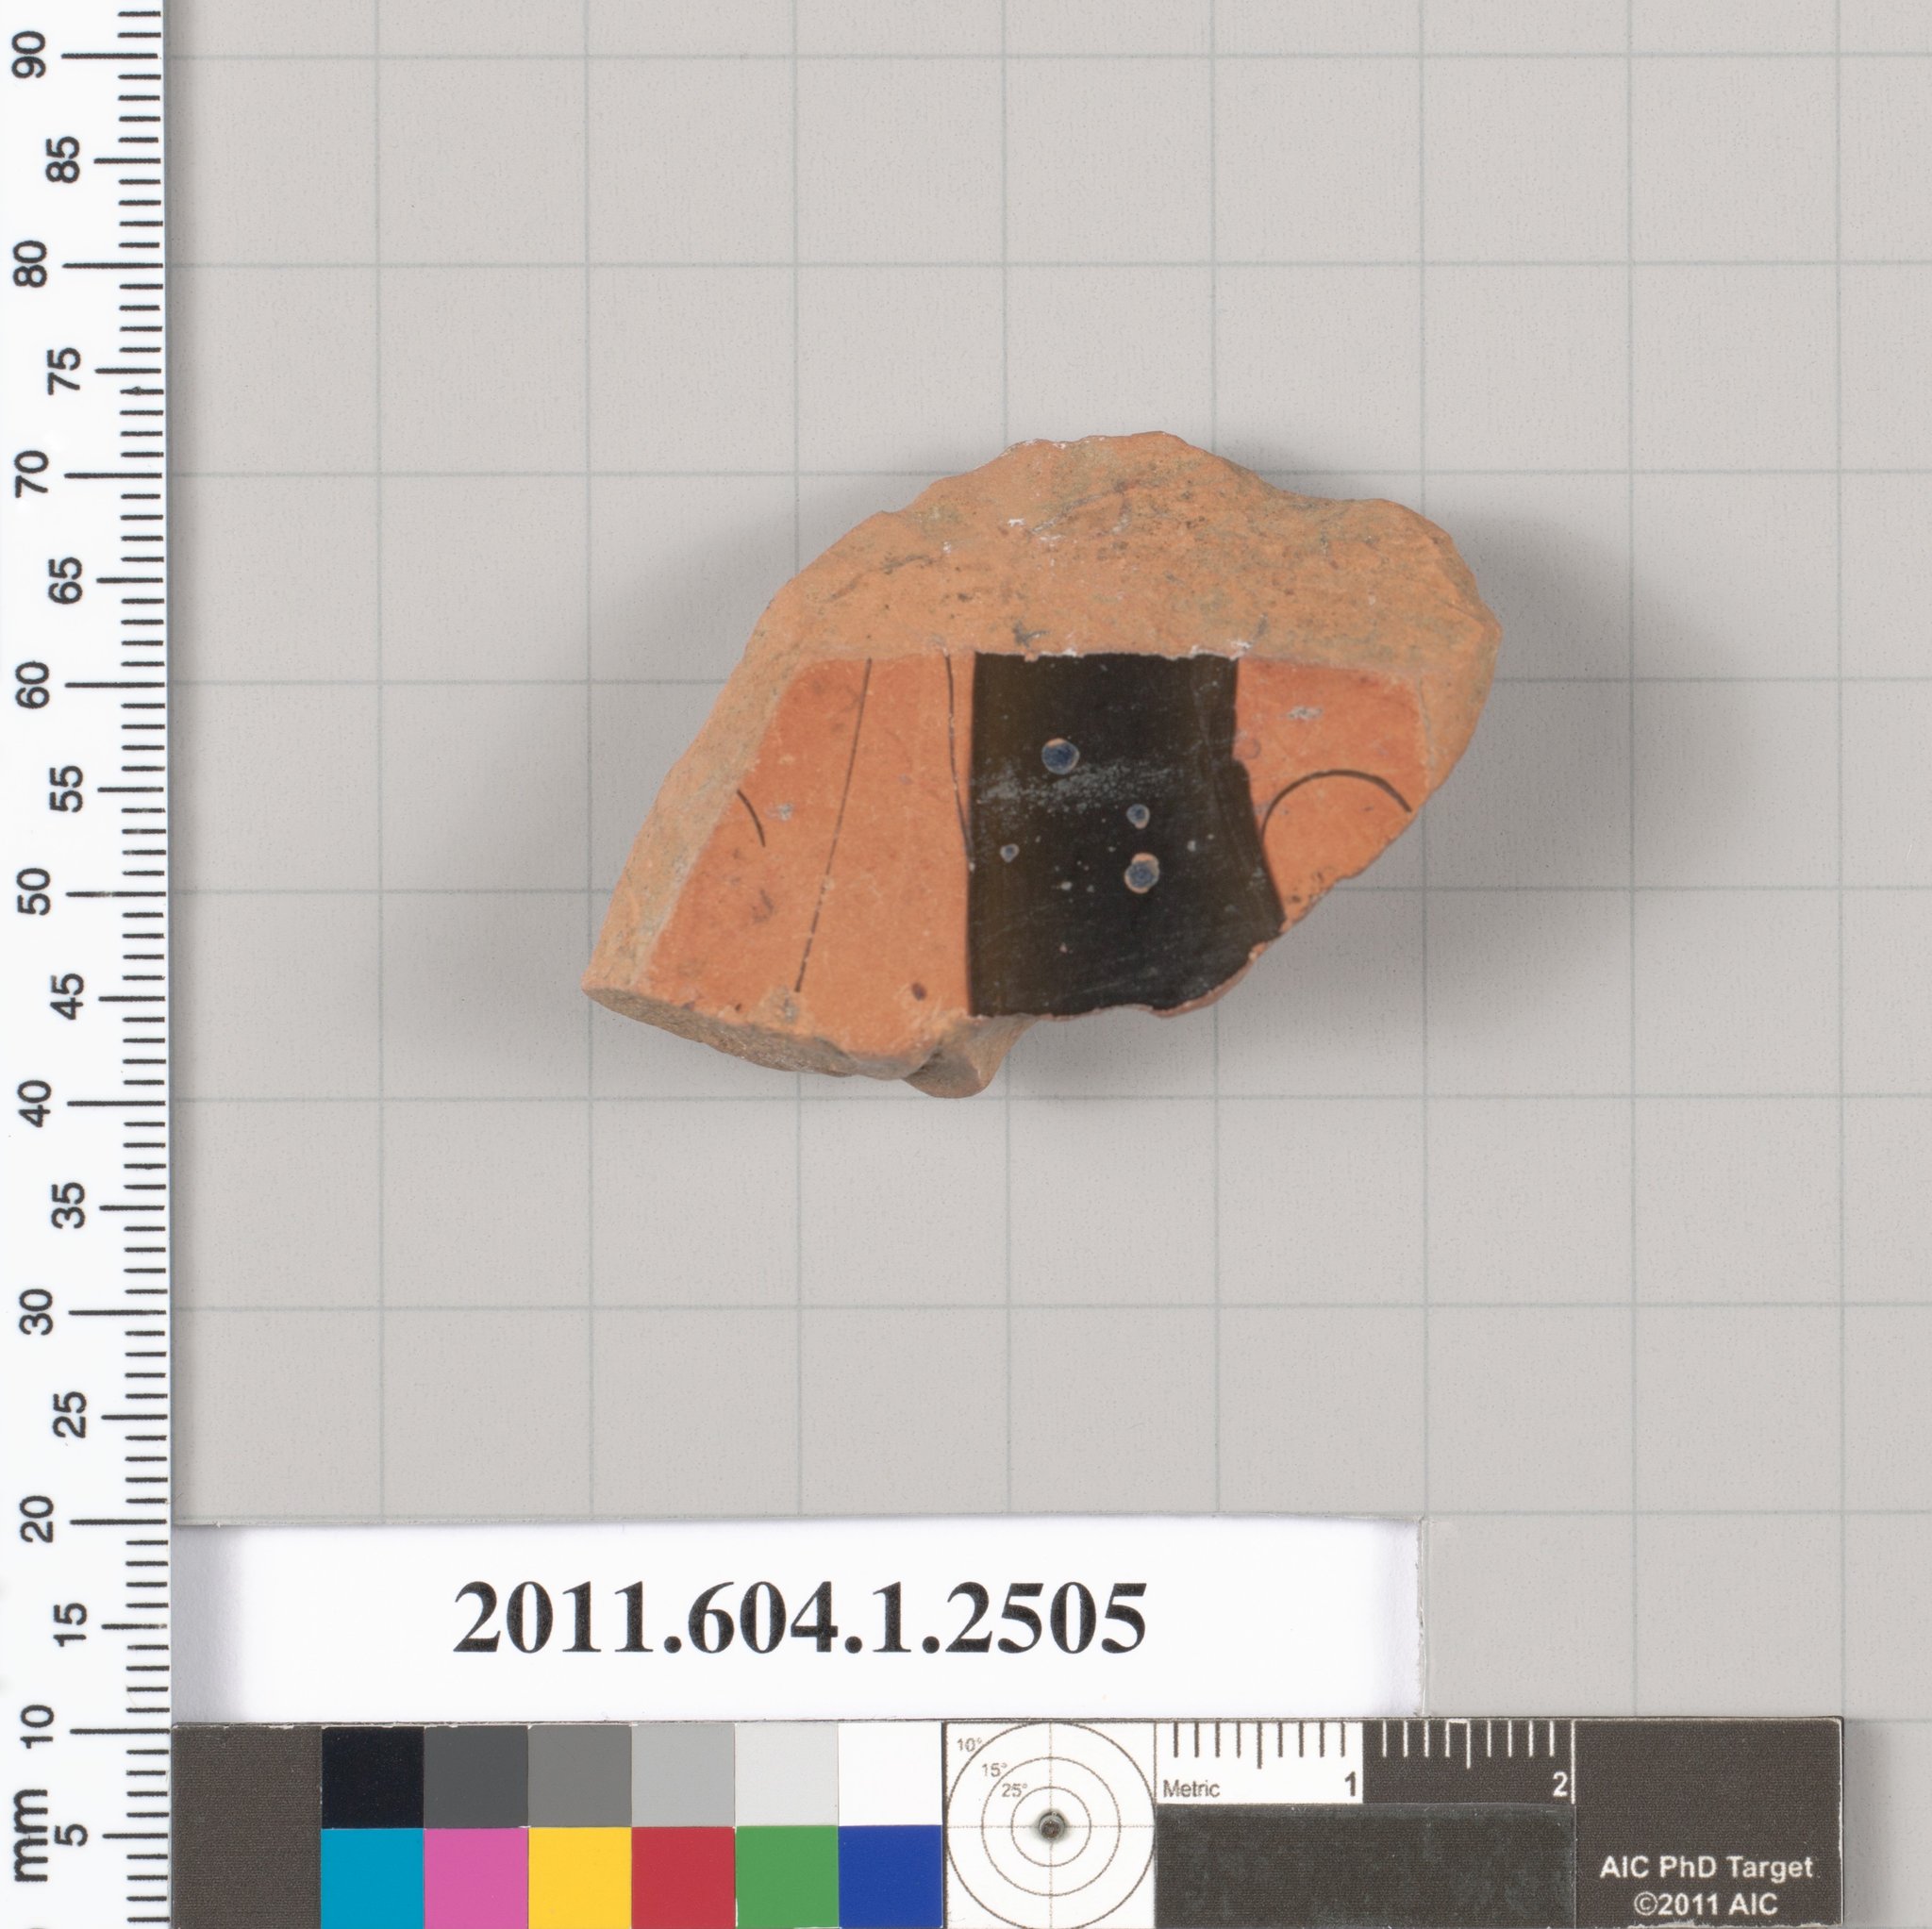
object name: kylix fragment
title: Terracotta fragment of a kylix (drinking cup)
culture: greek, attic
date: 475-451 BCE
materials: terracotta